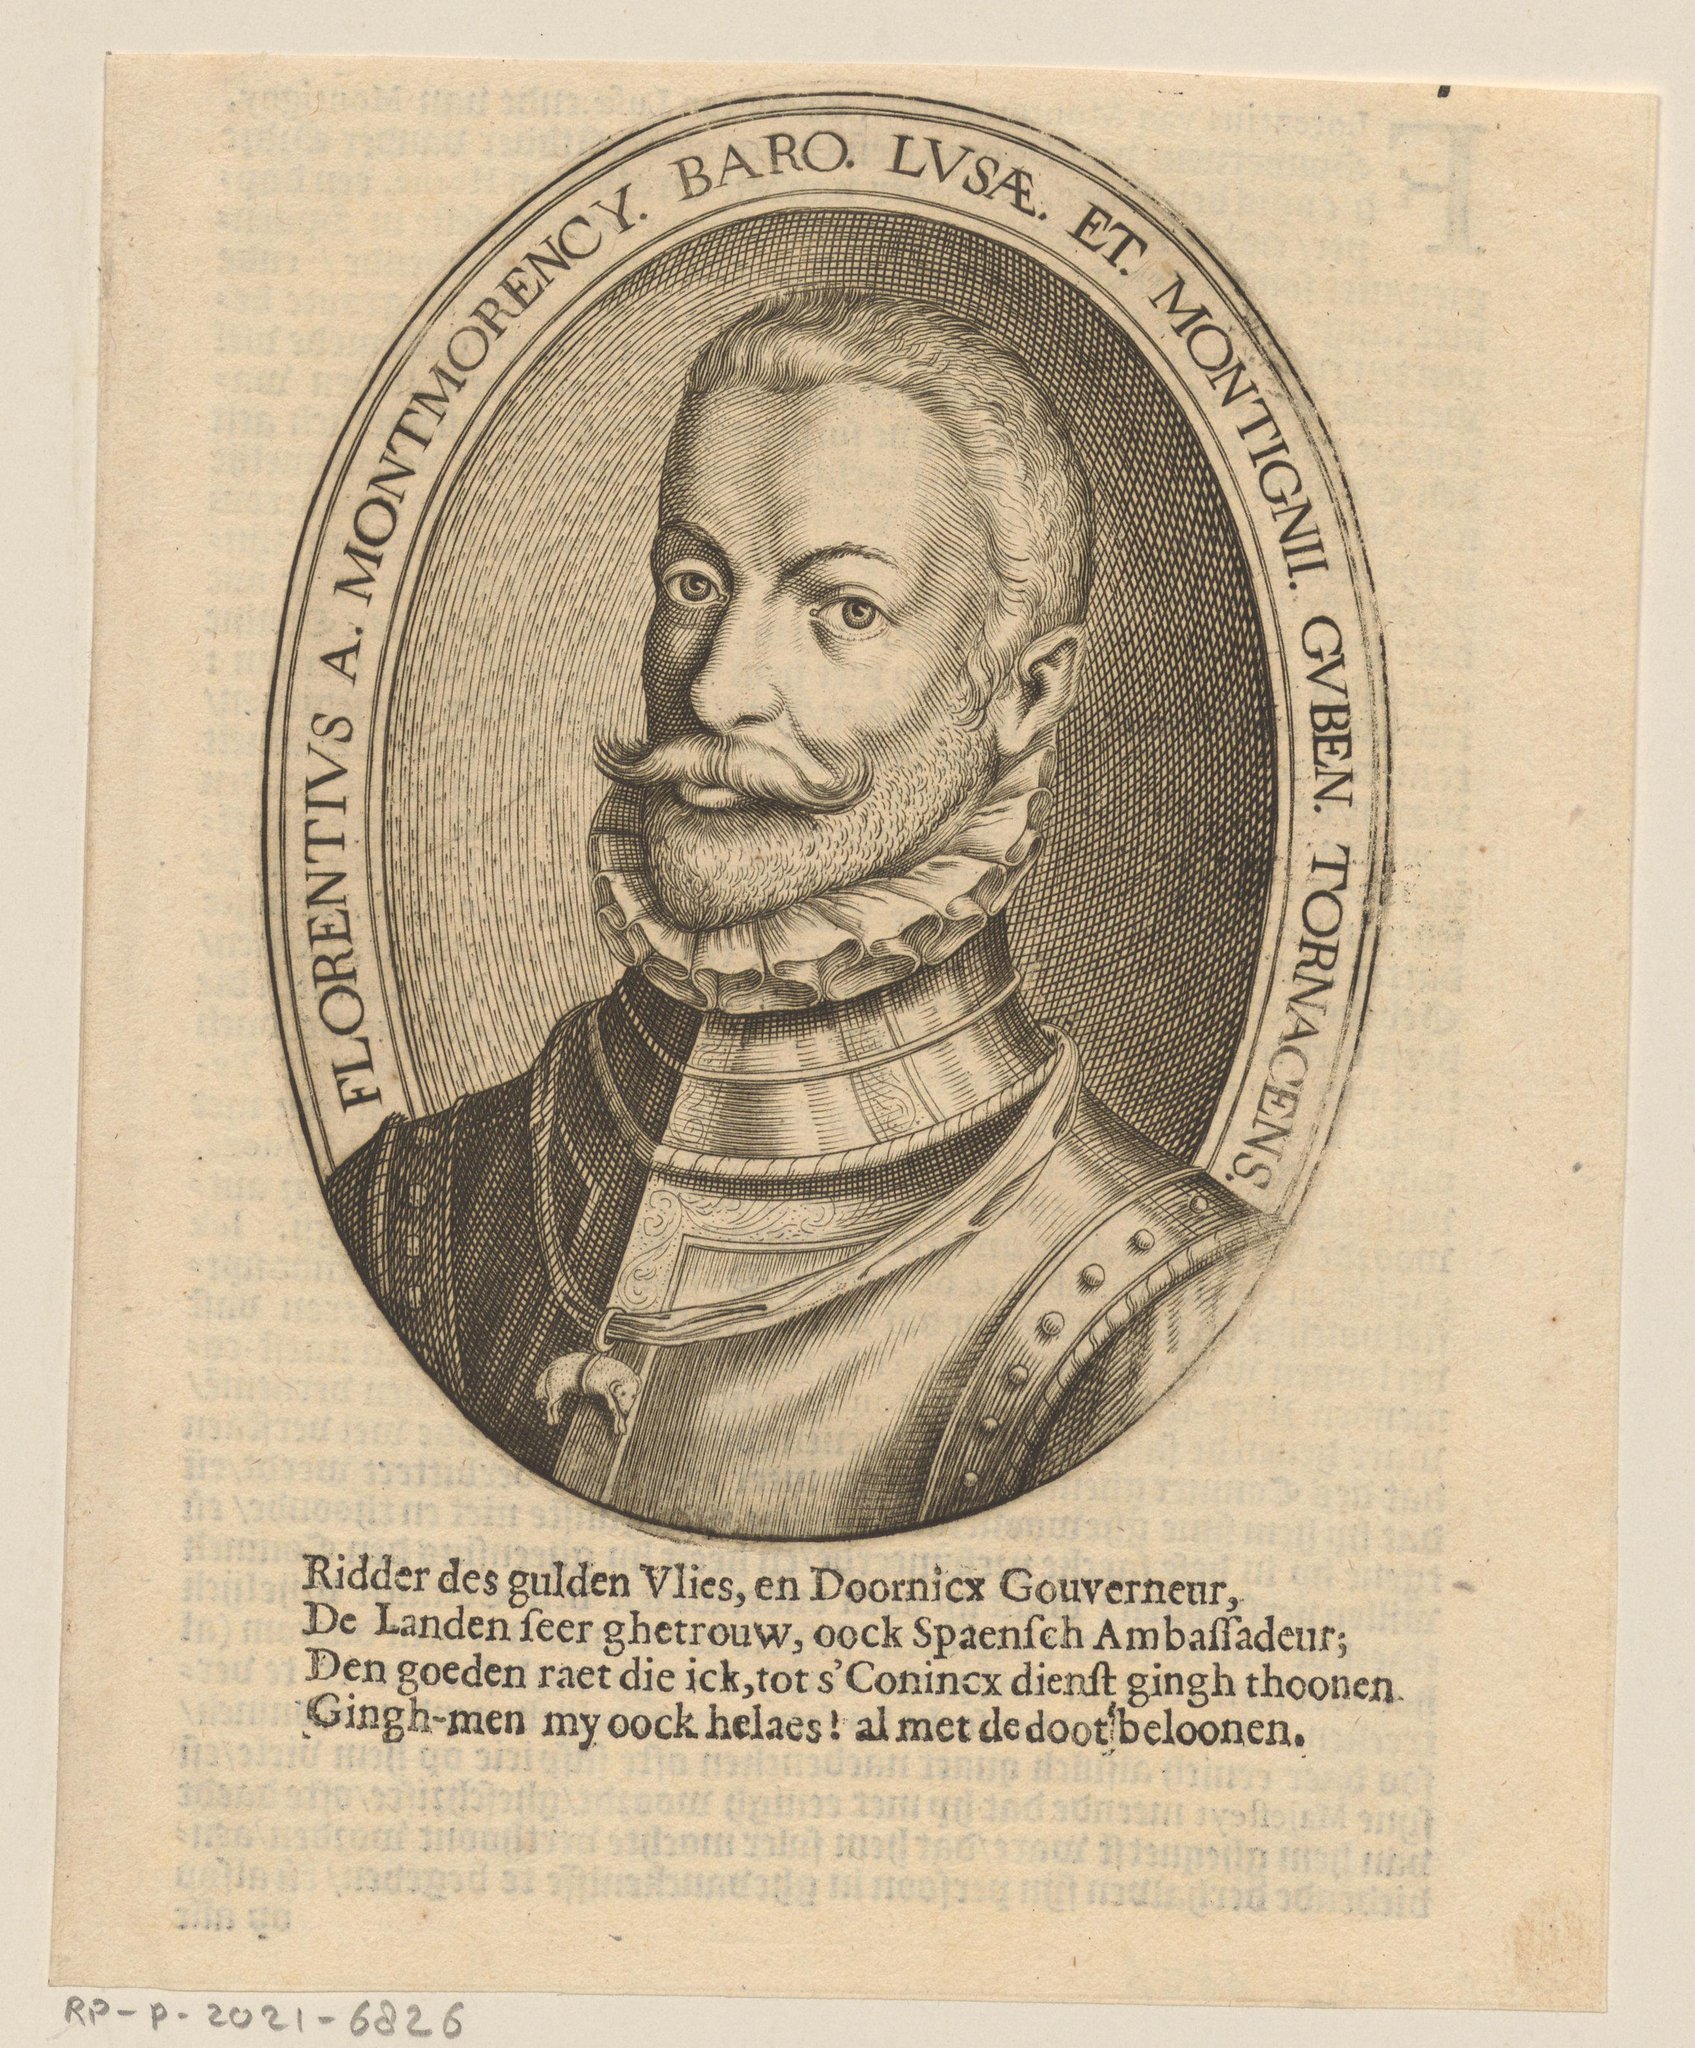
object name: print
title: Portret van Floris van Montmorency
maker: Anonymous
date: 1616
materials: paper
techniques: engraving, letterpress printing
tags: armour, historical persons, knighthood order of the golden fleece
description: Prent uit: Gysius, Johannes. Oorsprong ende voortgang der Neder-landtscher beroerten. S.l.s.n. 1616. Prent ook gebruikt in de Latijnse editie en de 1626-editie van dit werk.